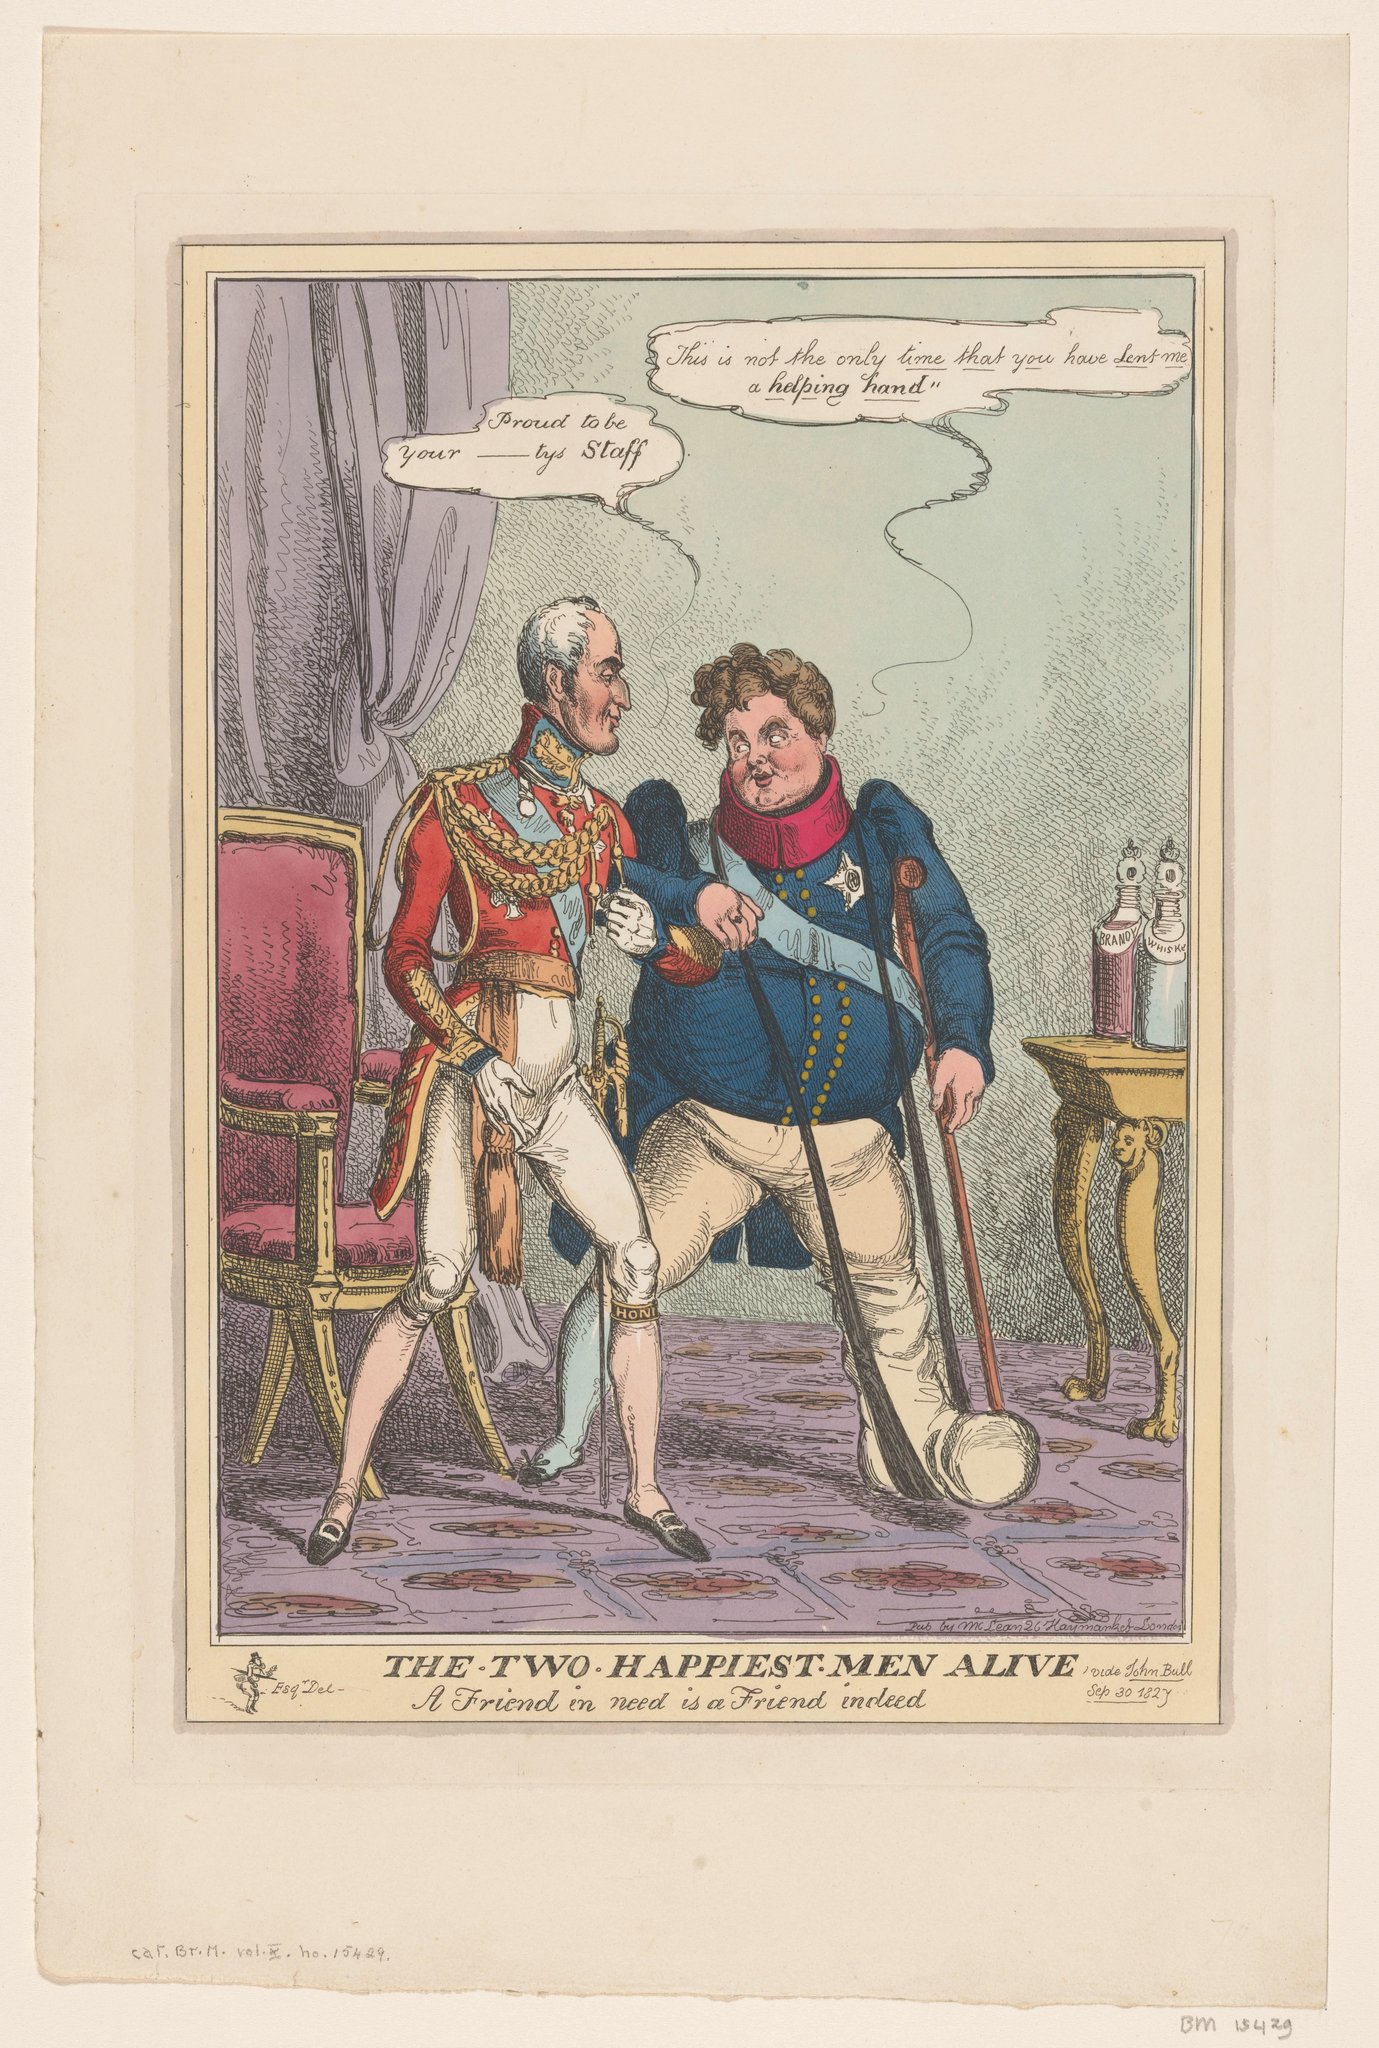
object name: cartoon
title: George IV en de hertog van Wellington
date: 1827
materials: paper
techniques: etching, hand coloring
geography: england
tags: walmer castle, arthur wellesley of wellington, george iv (koning van het verenigd koninkrijk), crutches, treatment by immobilization, sling, splint, plaster, etc., political caricatures and satires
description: Spotprent op de dankbaarheid van koning George IV aan de hertog van Wellington toen hij in 1827 een nieuwe post accepteerde op een nieuwe ministerie. De hertog ondersteunt de koning die met een been in het gips loopt.